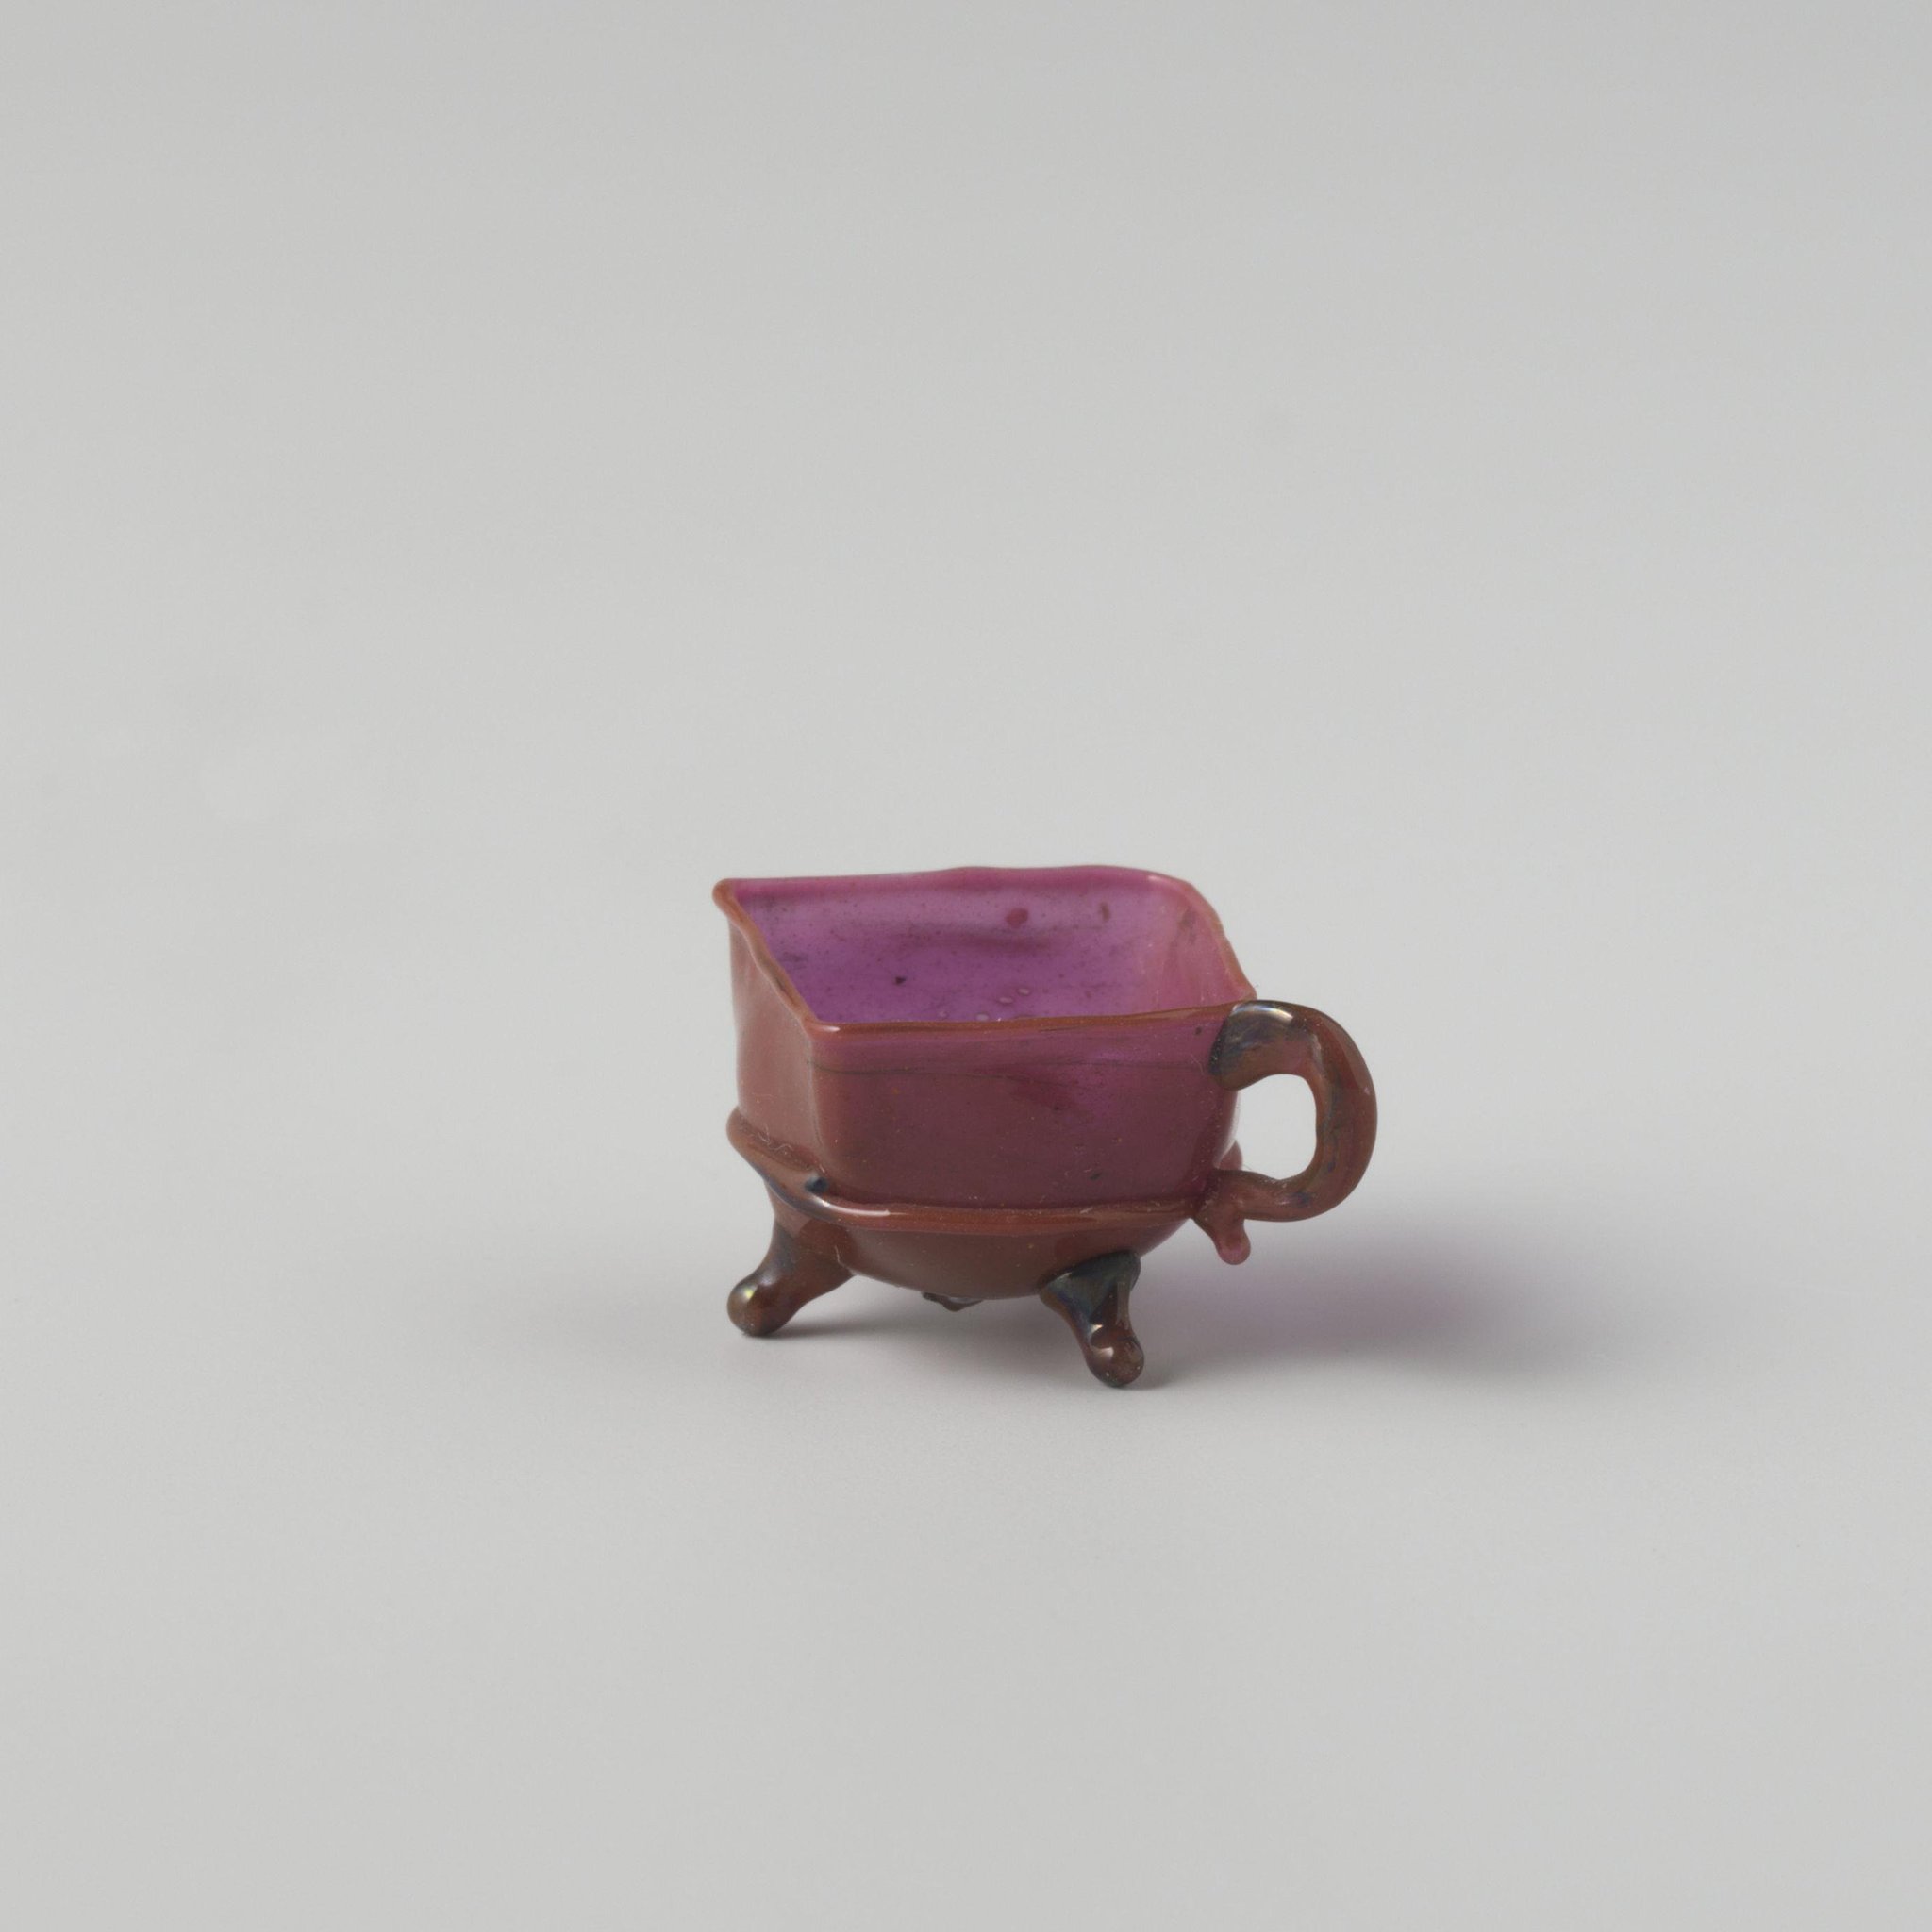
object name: miniature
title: Vierkante vuurtest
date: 1675-1700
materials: glass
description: Vierkante vuurtest op drie poten, vervaardigd van opaak, bruinpaars glas.